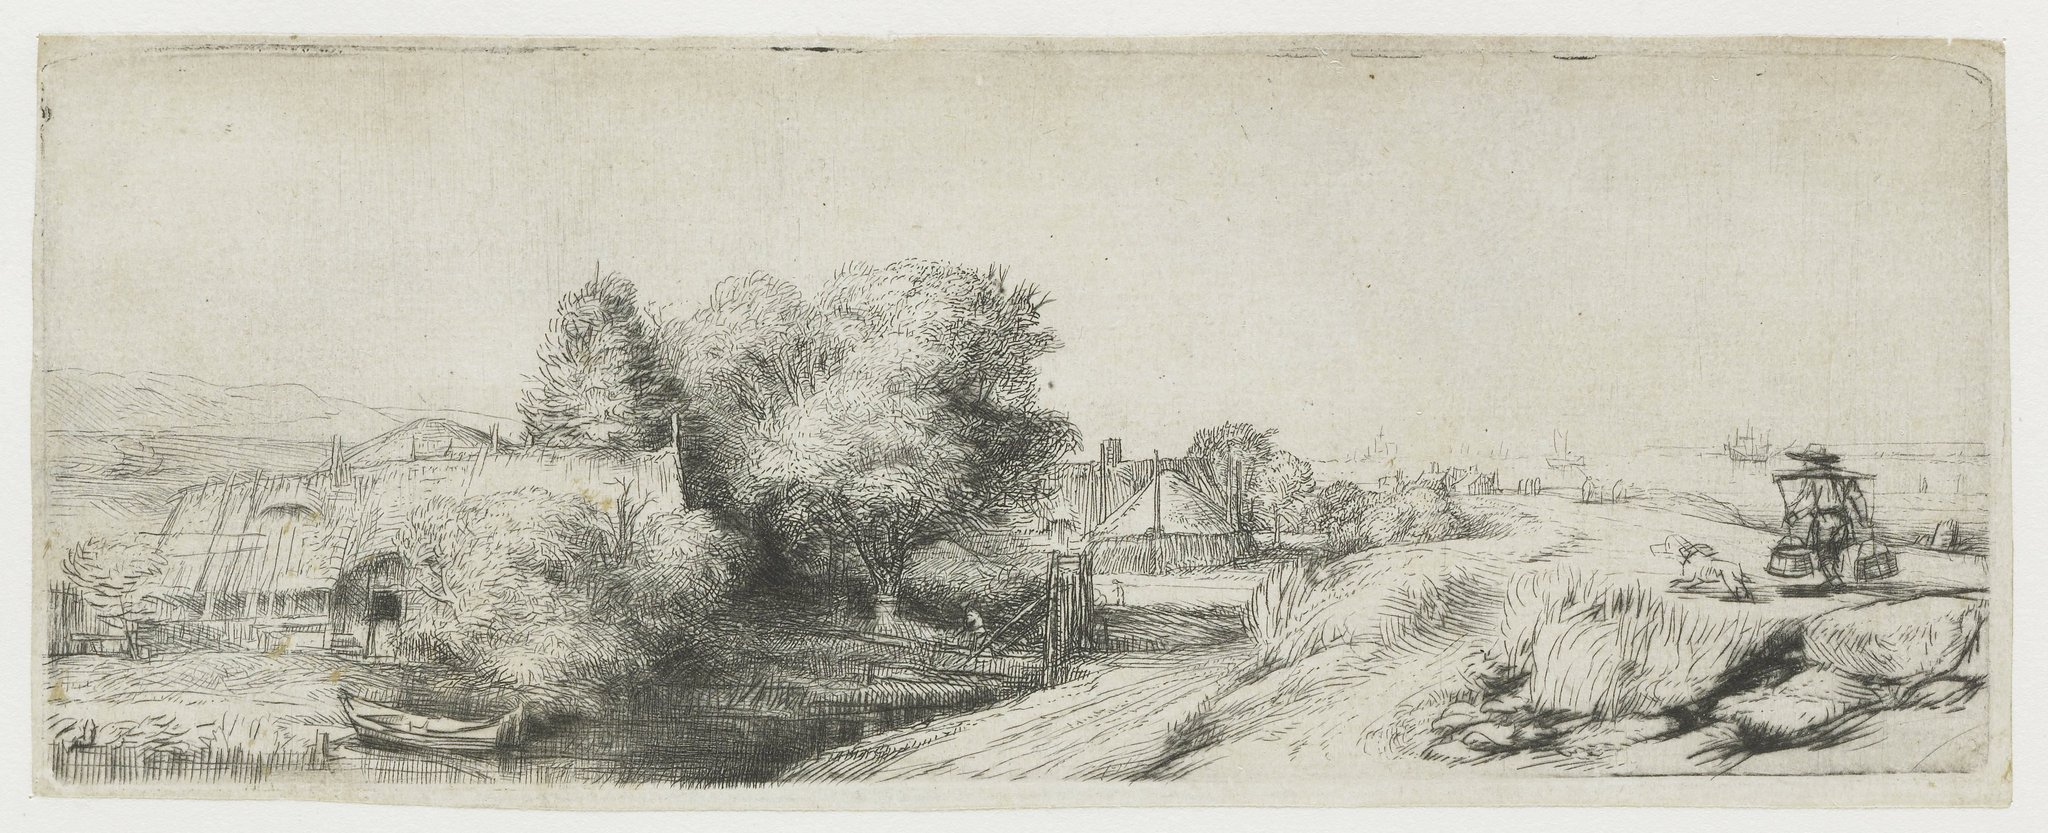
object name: print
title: View of the Diemerdijk with a milkman and cottages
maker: rembrandt van rijn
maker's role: draughtsman, painter, print maker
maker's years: 1606-1669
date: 1650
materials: paper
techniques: drypoint, etching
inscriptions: inscription: ‘111234’, collector's mark: Lugt 1614, collector's mark: Lugt 2228